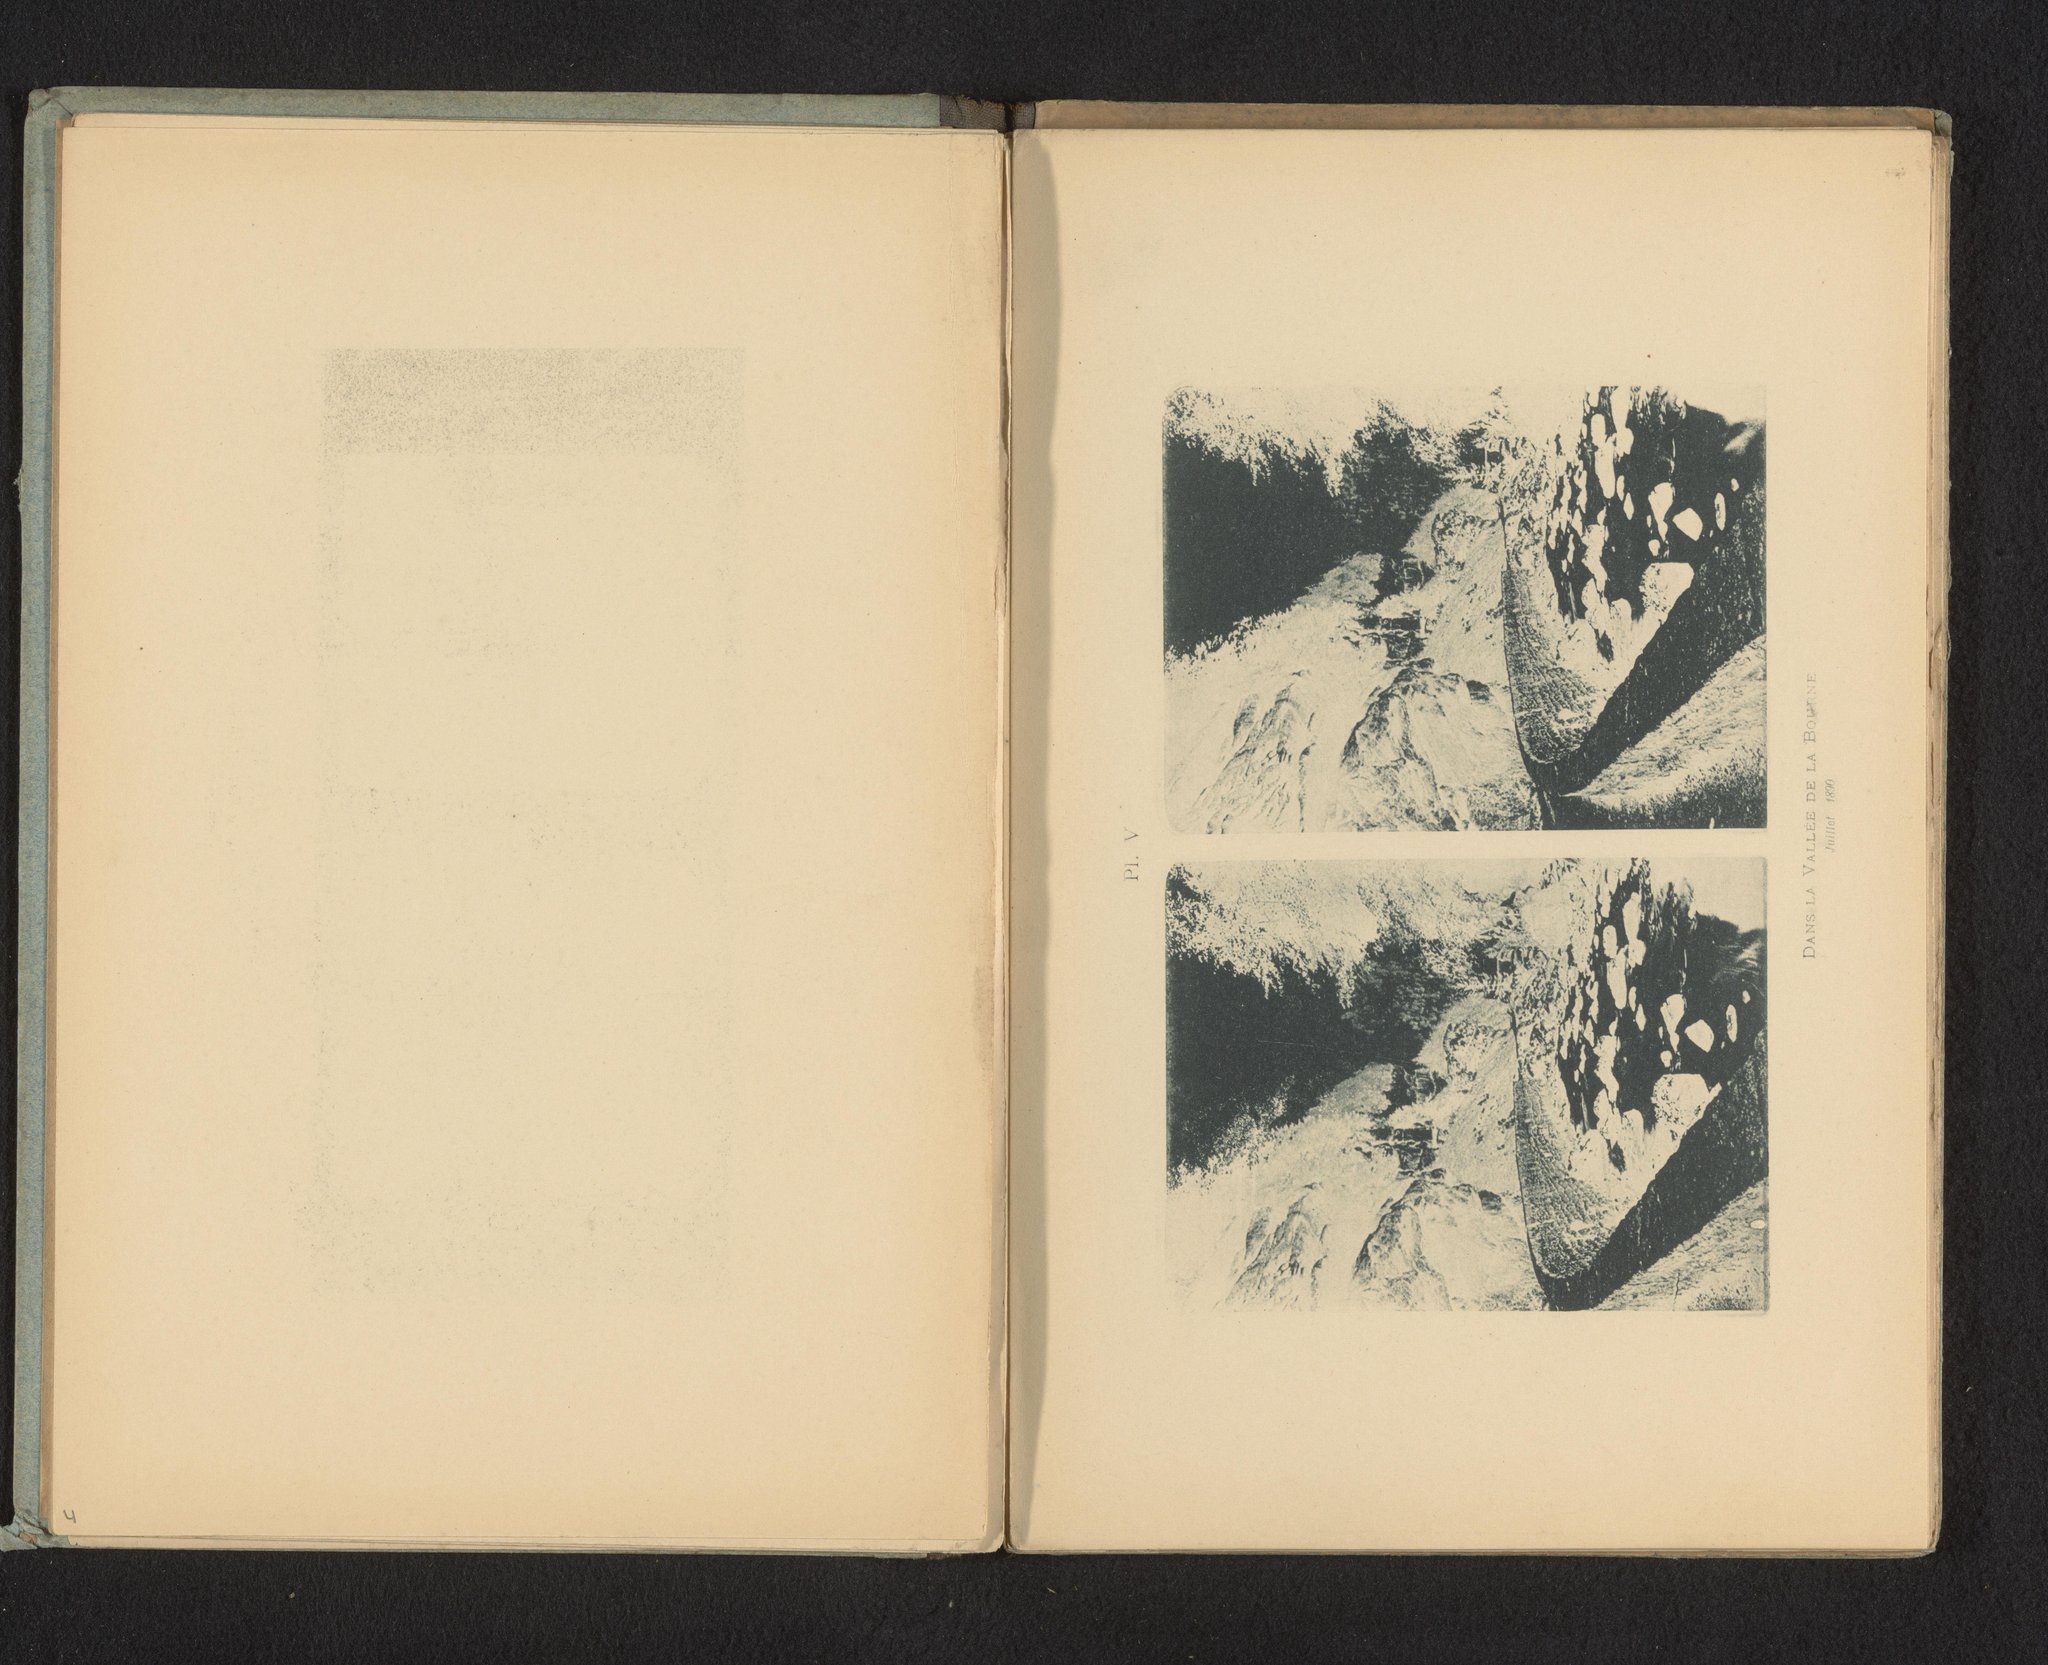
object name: page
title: Stereofoto van een gezicht op de Gorges de la Bourne in negatief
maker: adolphe louis donnadieu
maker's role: wetenschapper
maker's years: 1840-1911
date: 1882-1892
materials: paper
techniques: photograph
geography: france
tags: ravine, chasm, abyss, canyon, france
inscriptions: inscription: ‘Pl. V’, inscription: ‘Juillet 1890’